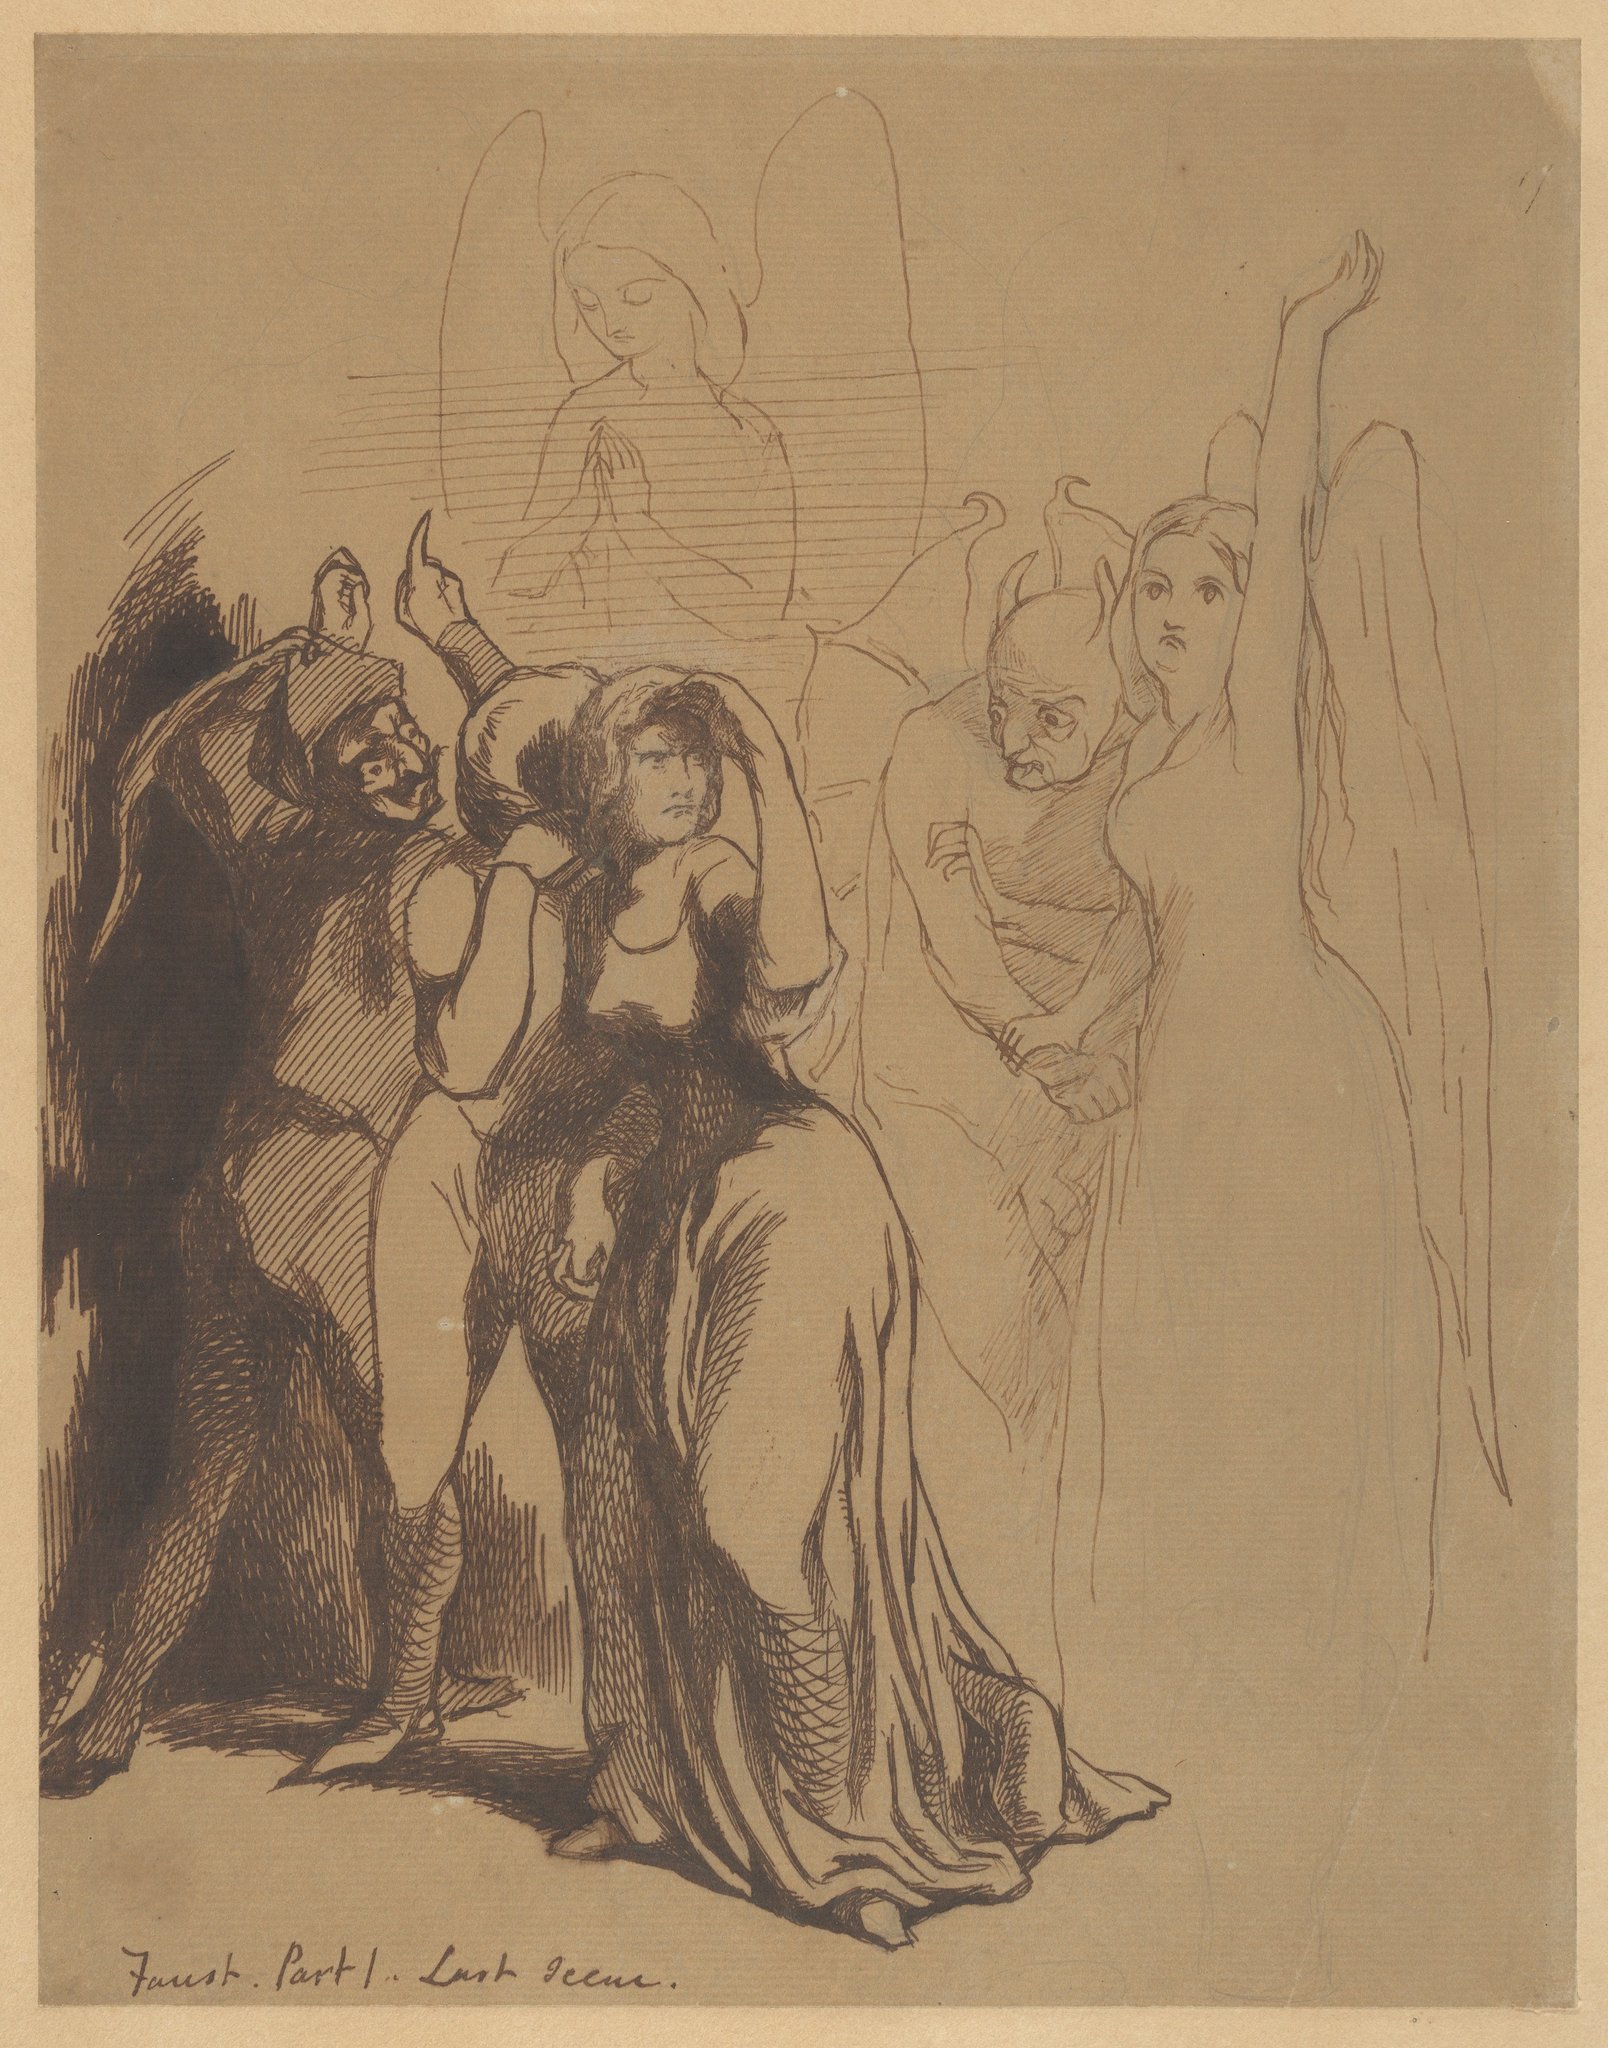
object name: drawing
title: Faust: Part 1. Last Scene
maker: dante gabriel rossetti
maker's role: artist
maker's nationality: british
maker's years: 1828-1882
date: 1846-1848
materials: graphite, ink, paper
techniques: brush, pen, wash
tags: women,angels,devil